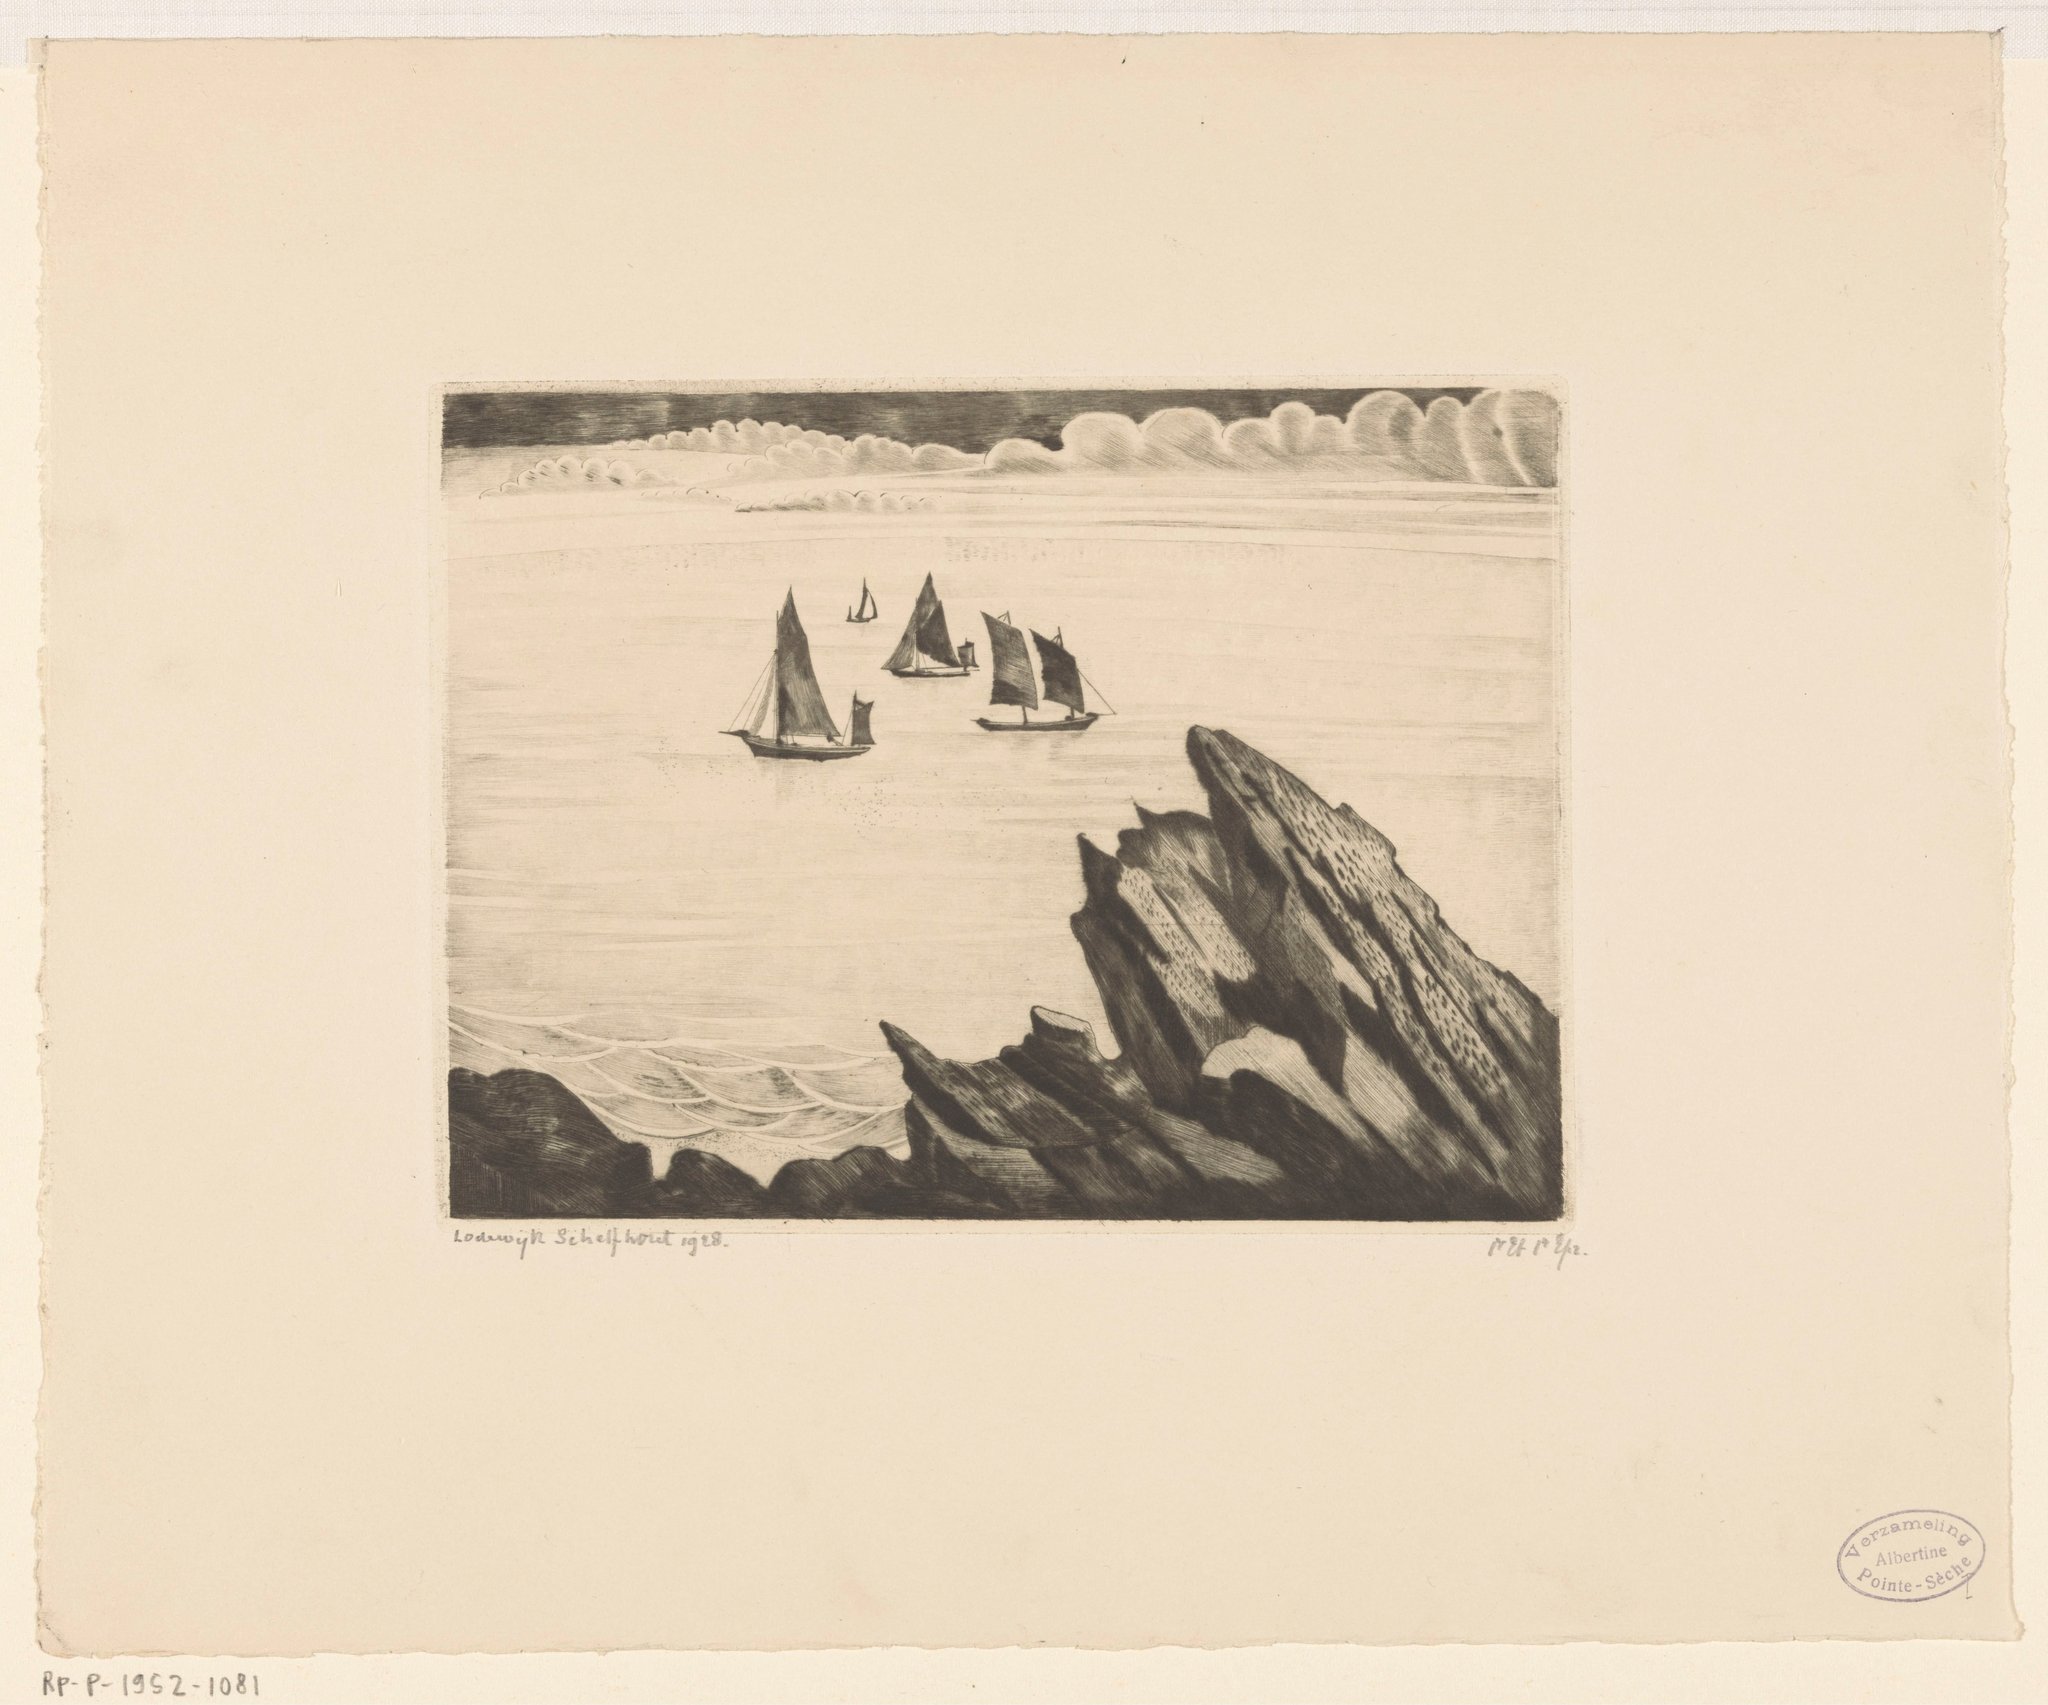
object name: print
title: Un soir en Bretagne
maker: lodewijk schelfhout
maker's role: draughtsman, print maker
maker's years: 1881-1943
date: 1928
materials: paper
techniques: drypoint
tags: sailing-ship, sailing-boat, rocky coast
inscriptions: collector's mark: Lugt 2228, collector's mark: Lugt 5i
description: Vier zeilschepen langs de kust van Bretagne. Op de voorgrond rotsen.